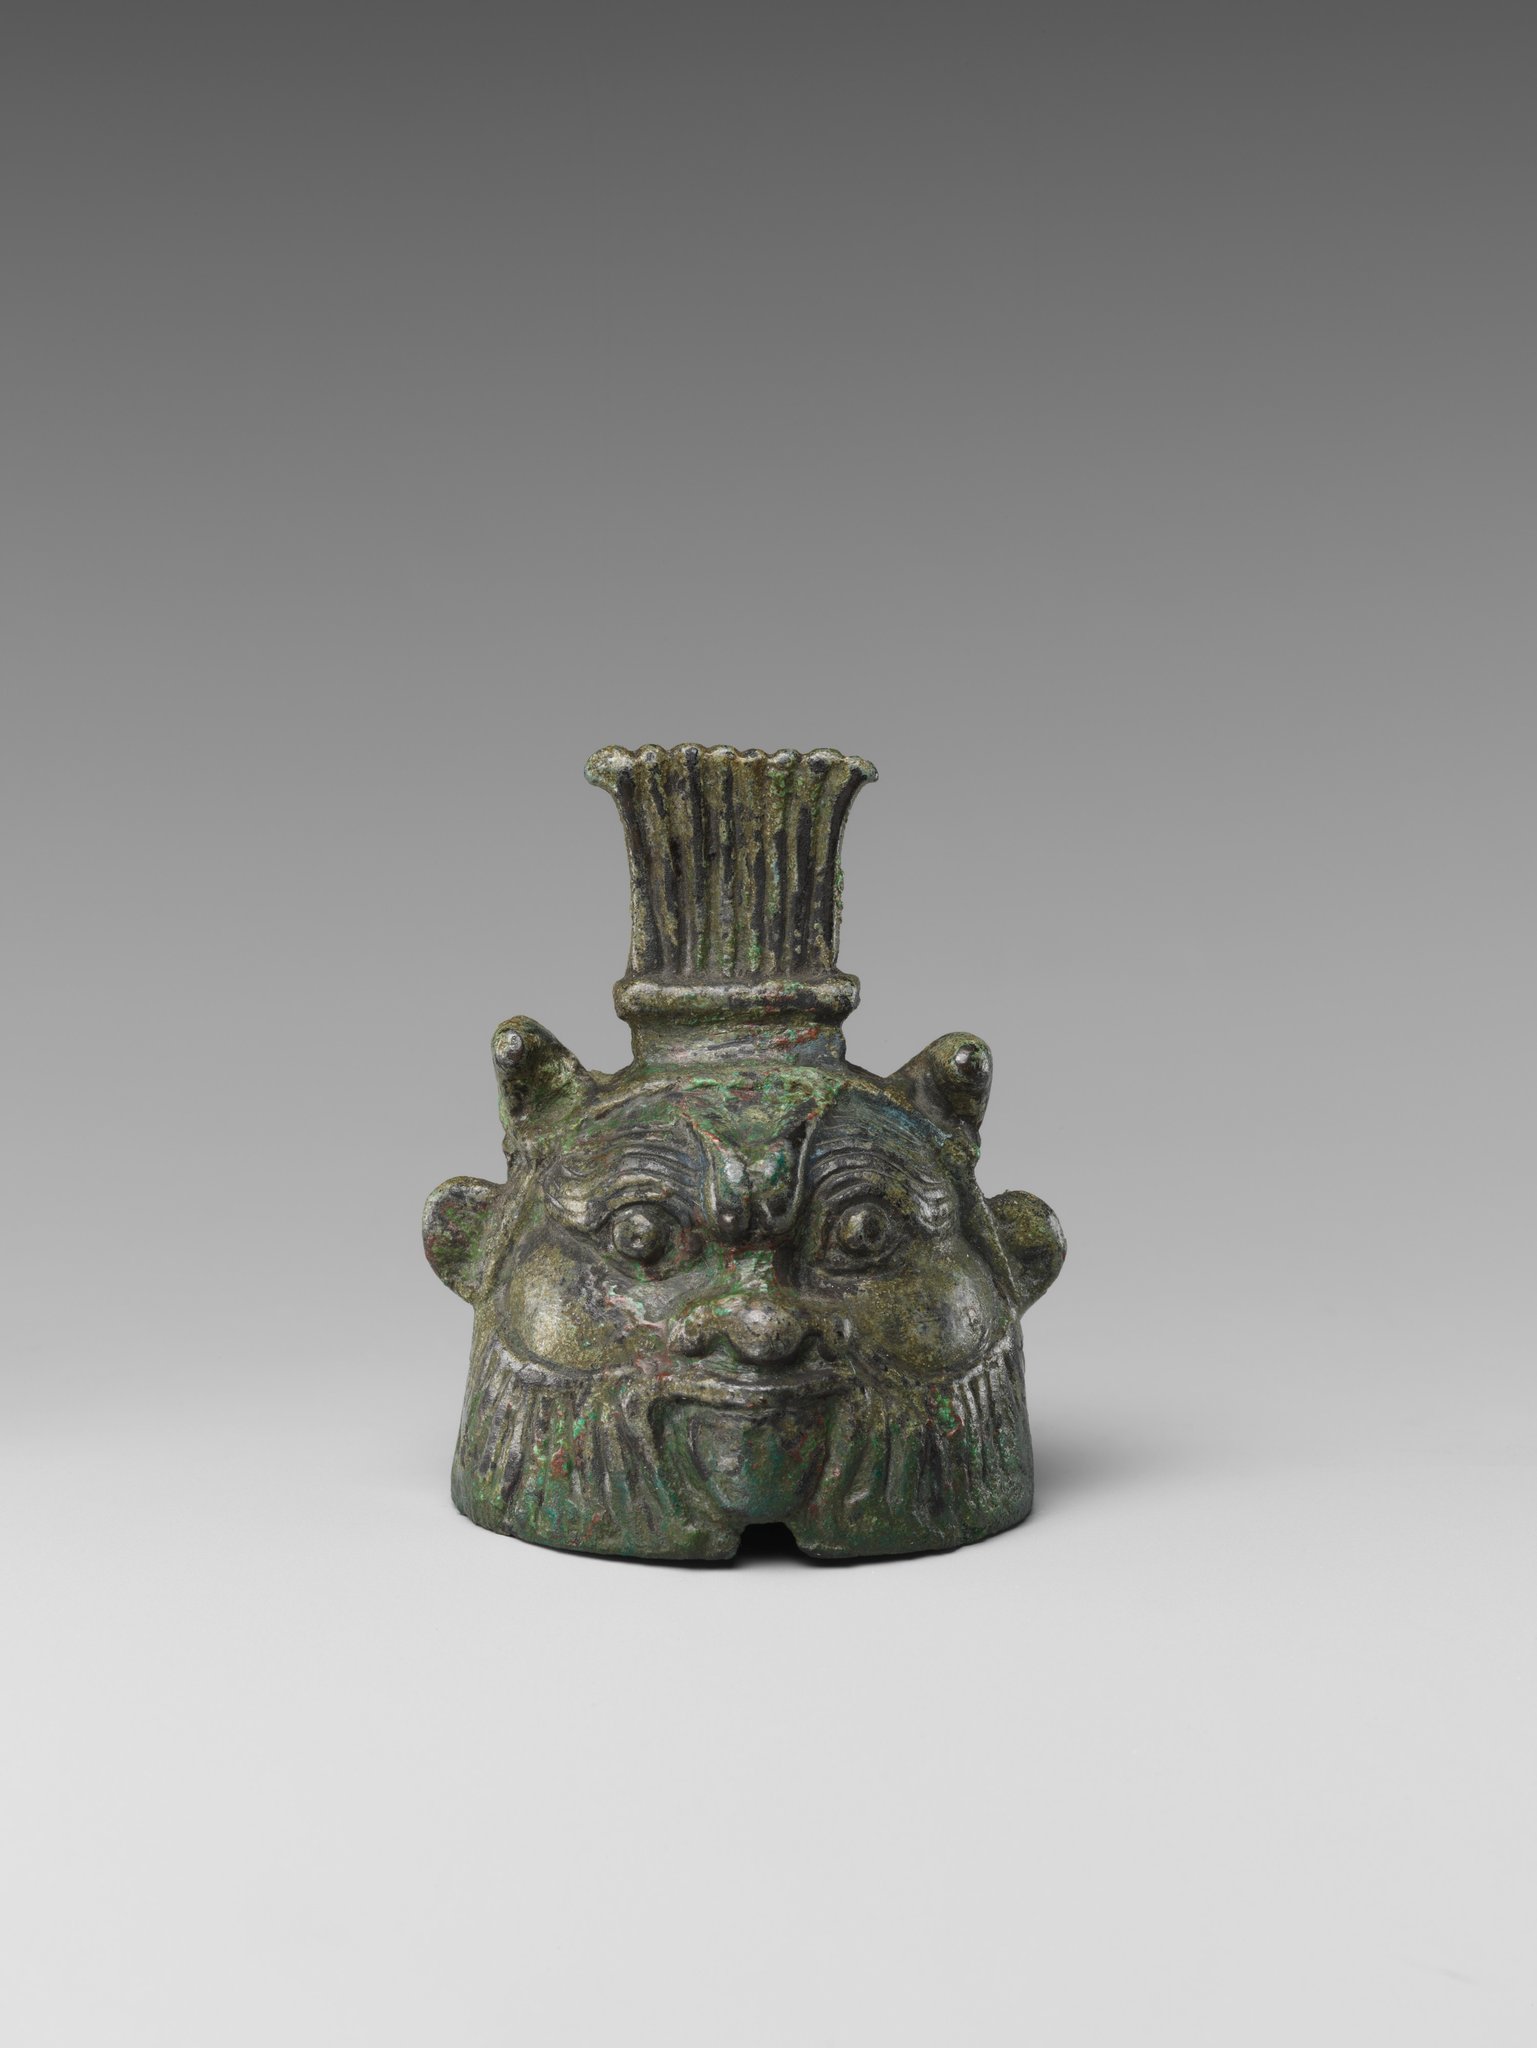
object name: music, bell, be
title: Bell in the form of Bes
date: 332-330 BCE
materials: metal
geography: egypt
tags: bes